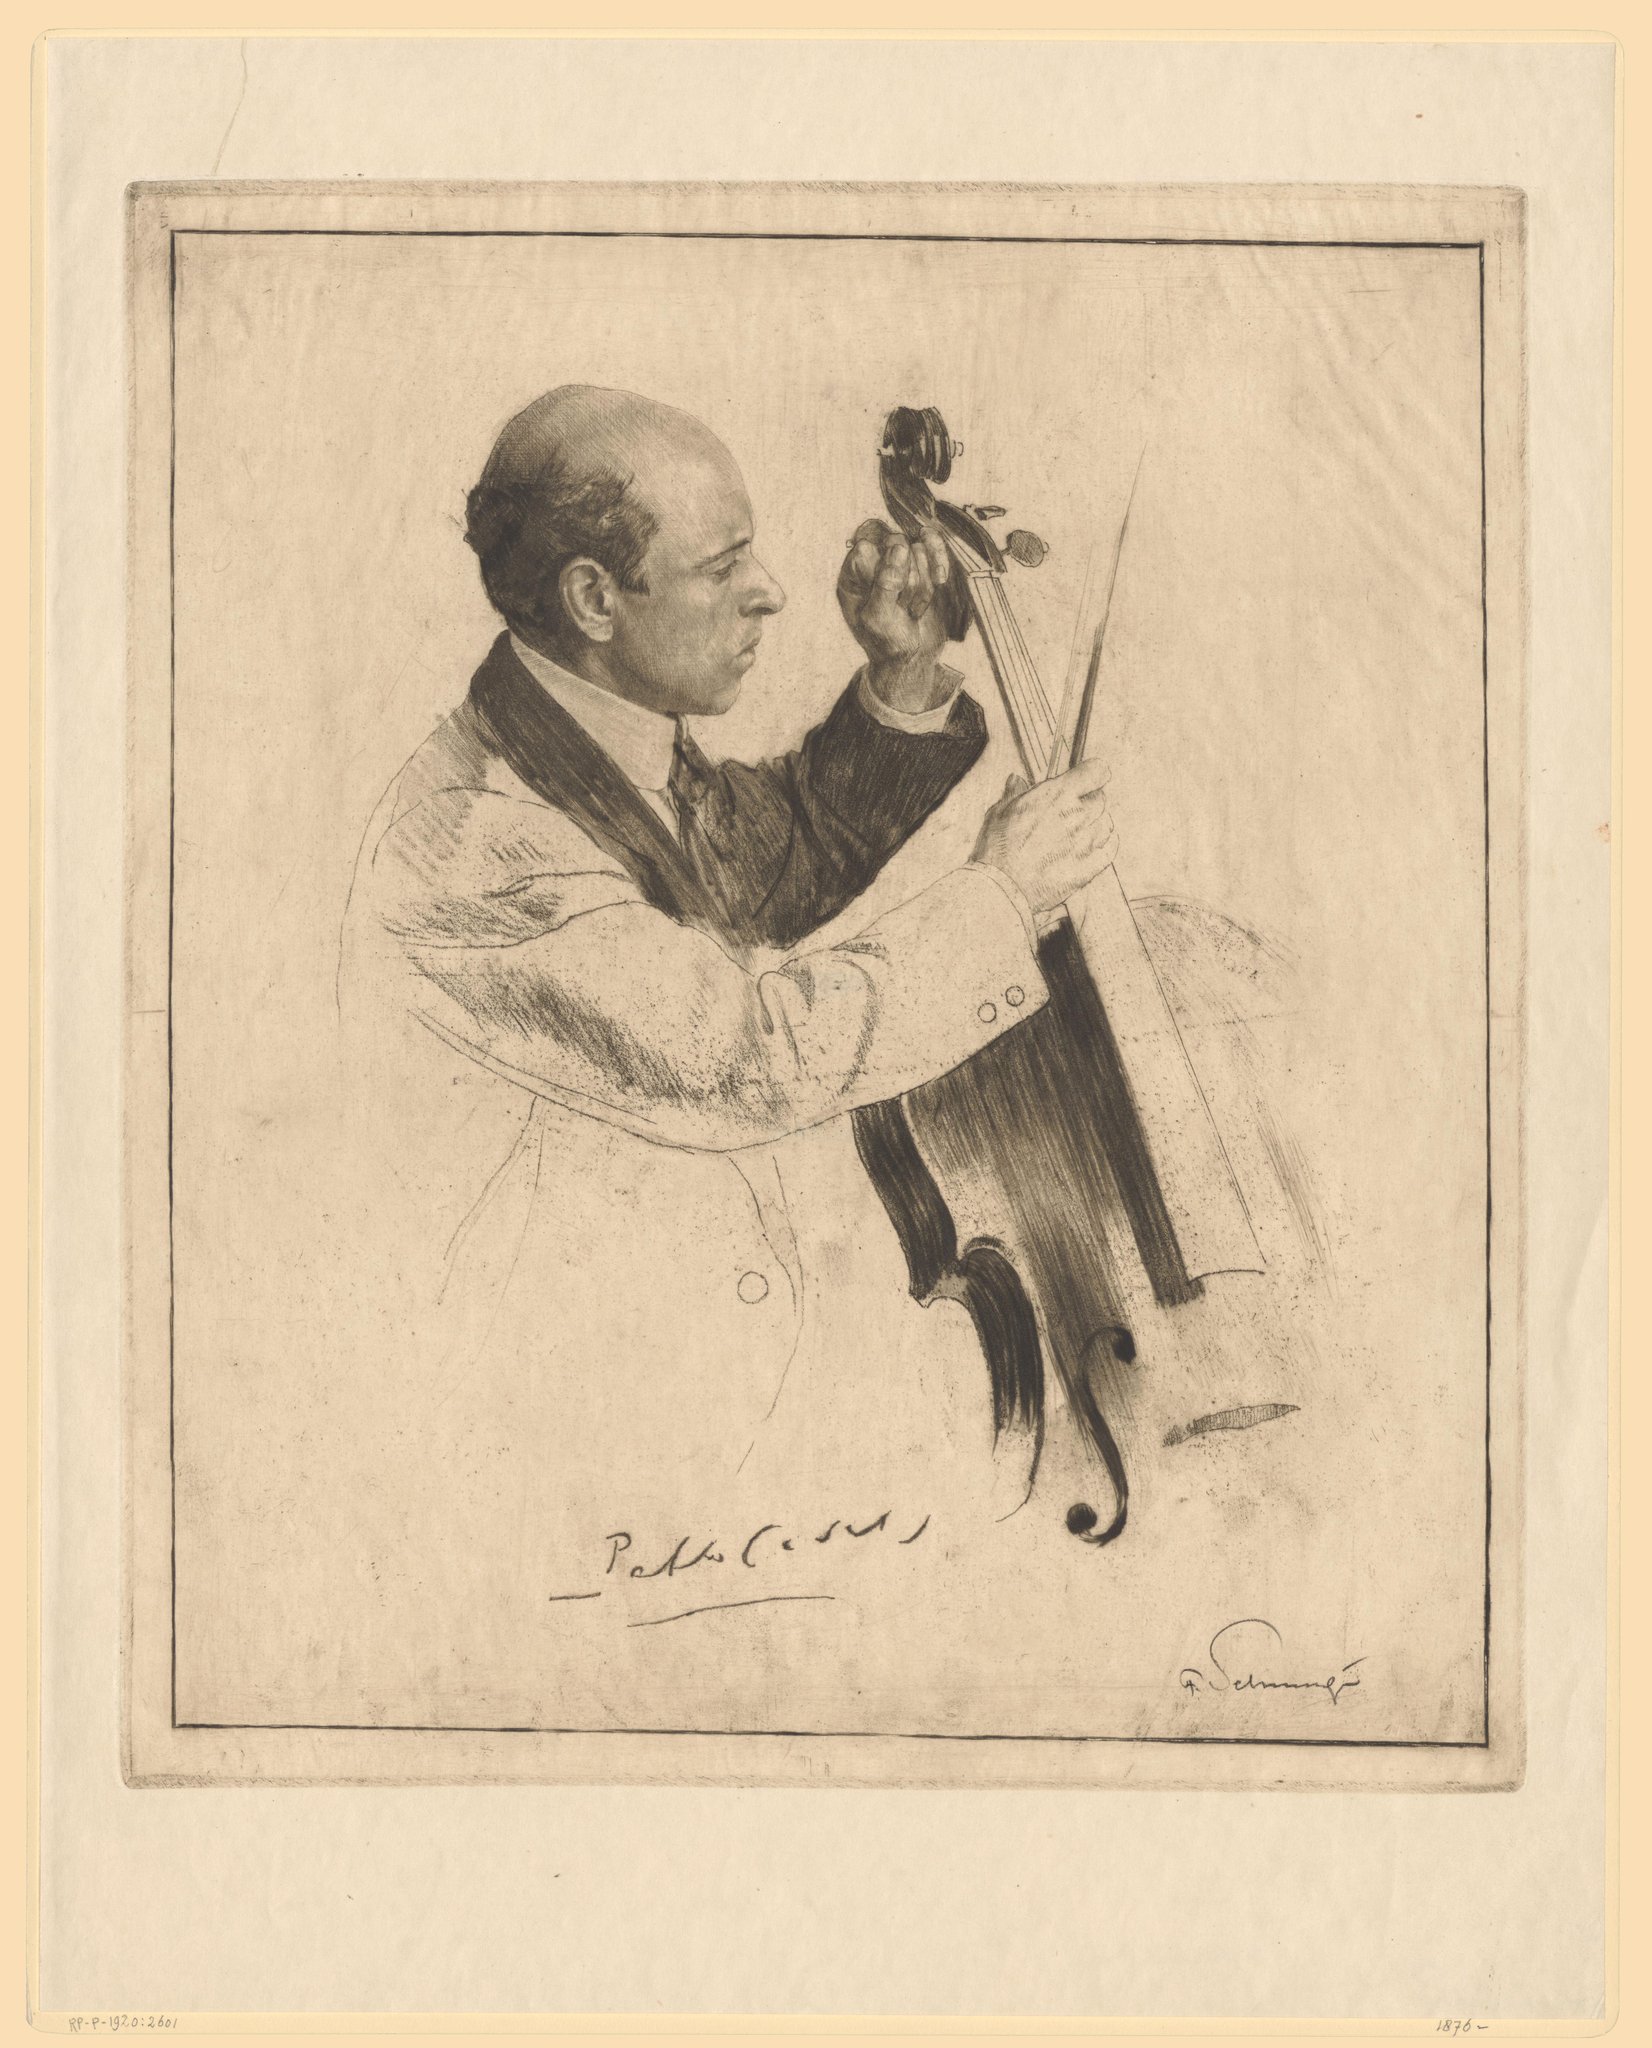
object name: print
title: Portret van Pablo Casals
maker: ferdinand schmutzer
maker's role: painter, print maker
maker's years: 1870-1928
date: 1888-1920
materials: paper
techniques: drypoint, etching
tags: musician, historical persons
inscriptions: collector's mark: Lugt 2228